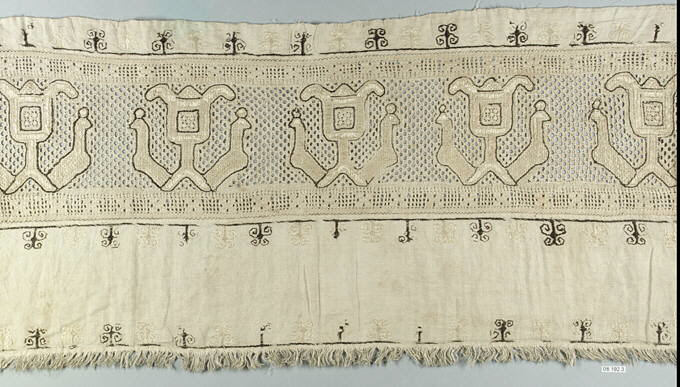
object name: border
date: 1701-1800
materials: linen, silk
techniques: embroidery